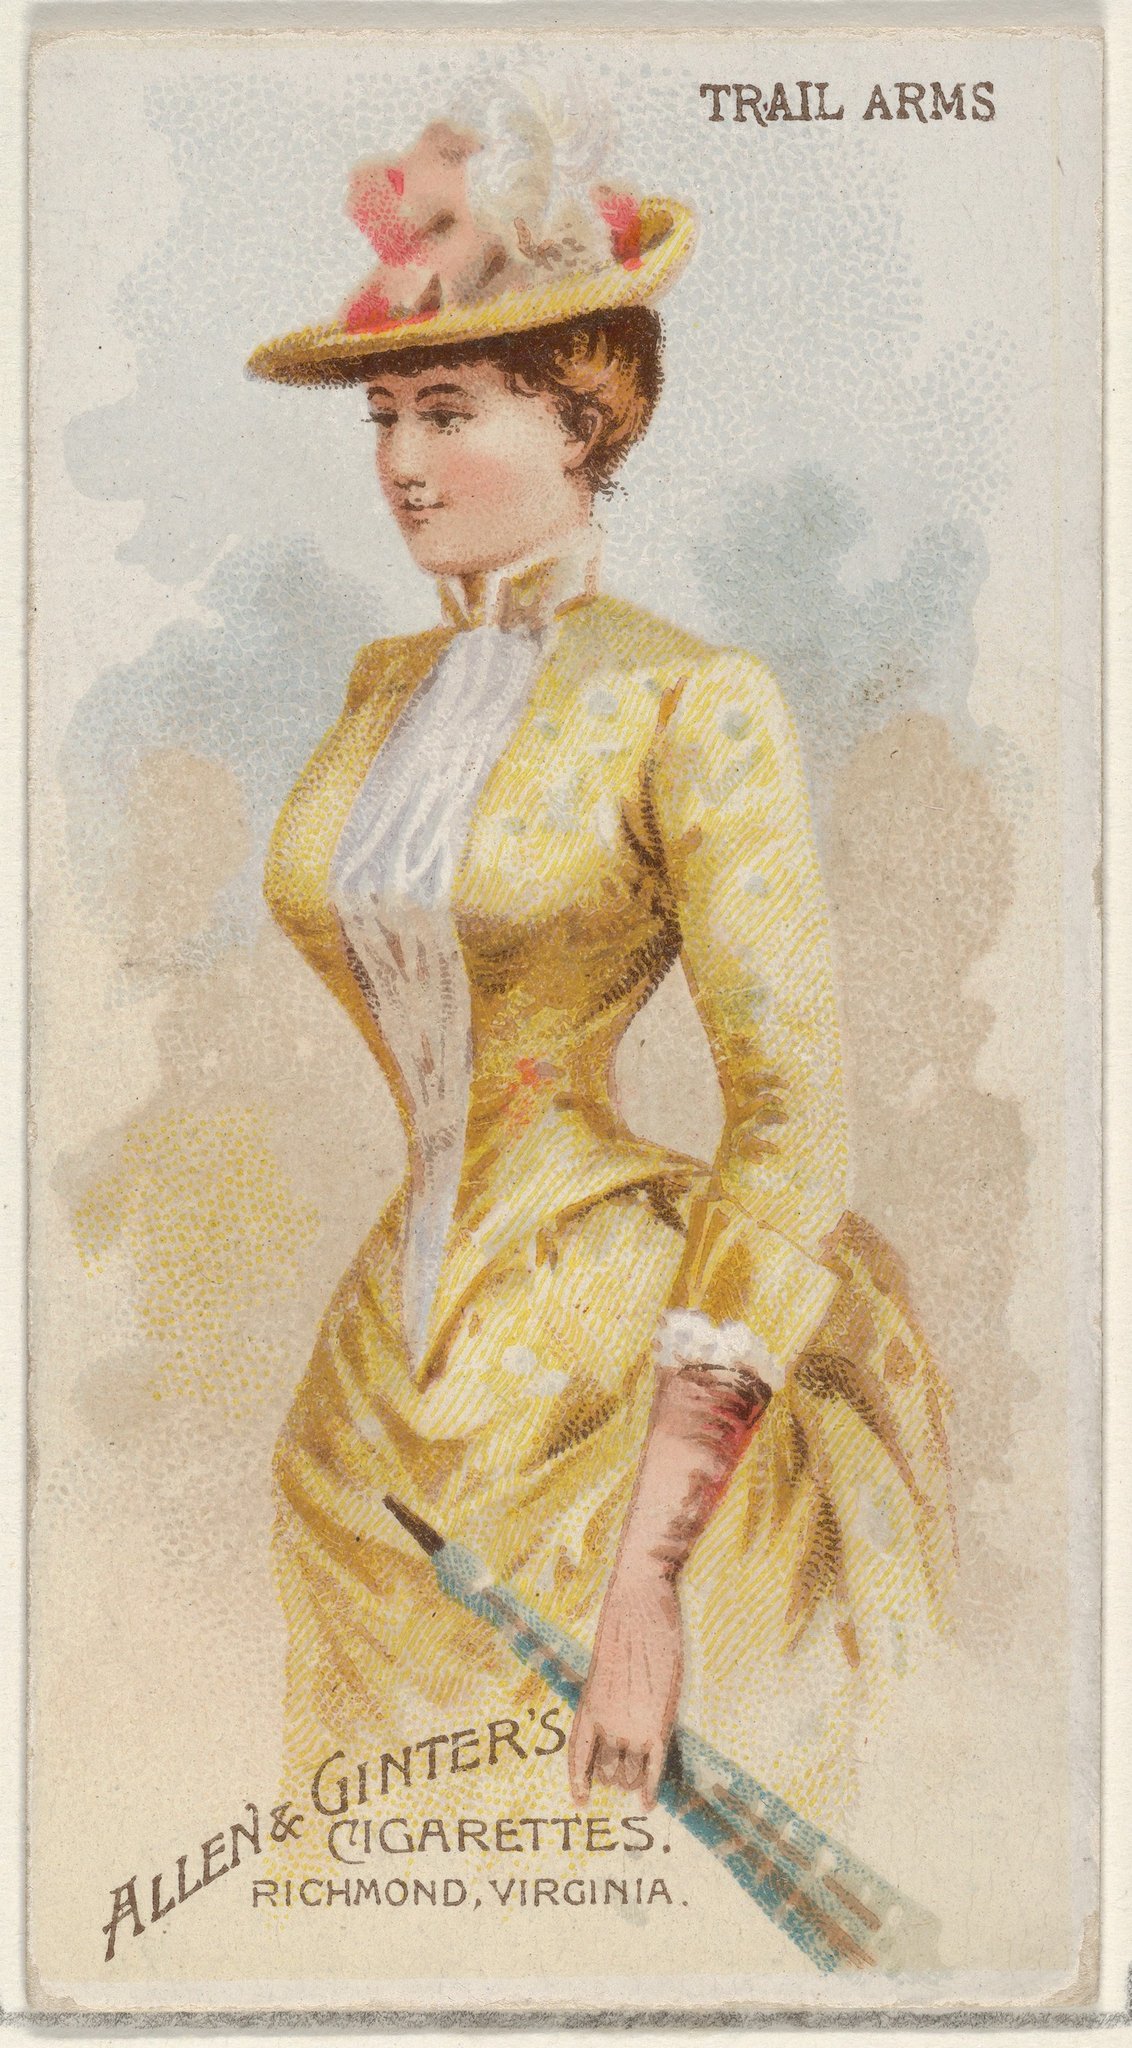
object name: print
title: Trail Arms, from the Parasol Drills series (N18) for Allen & Ginter Cigarettes Brands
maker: allen & ginter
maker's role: publisher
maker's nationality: american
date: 1888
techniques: color lithograph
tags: women